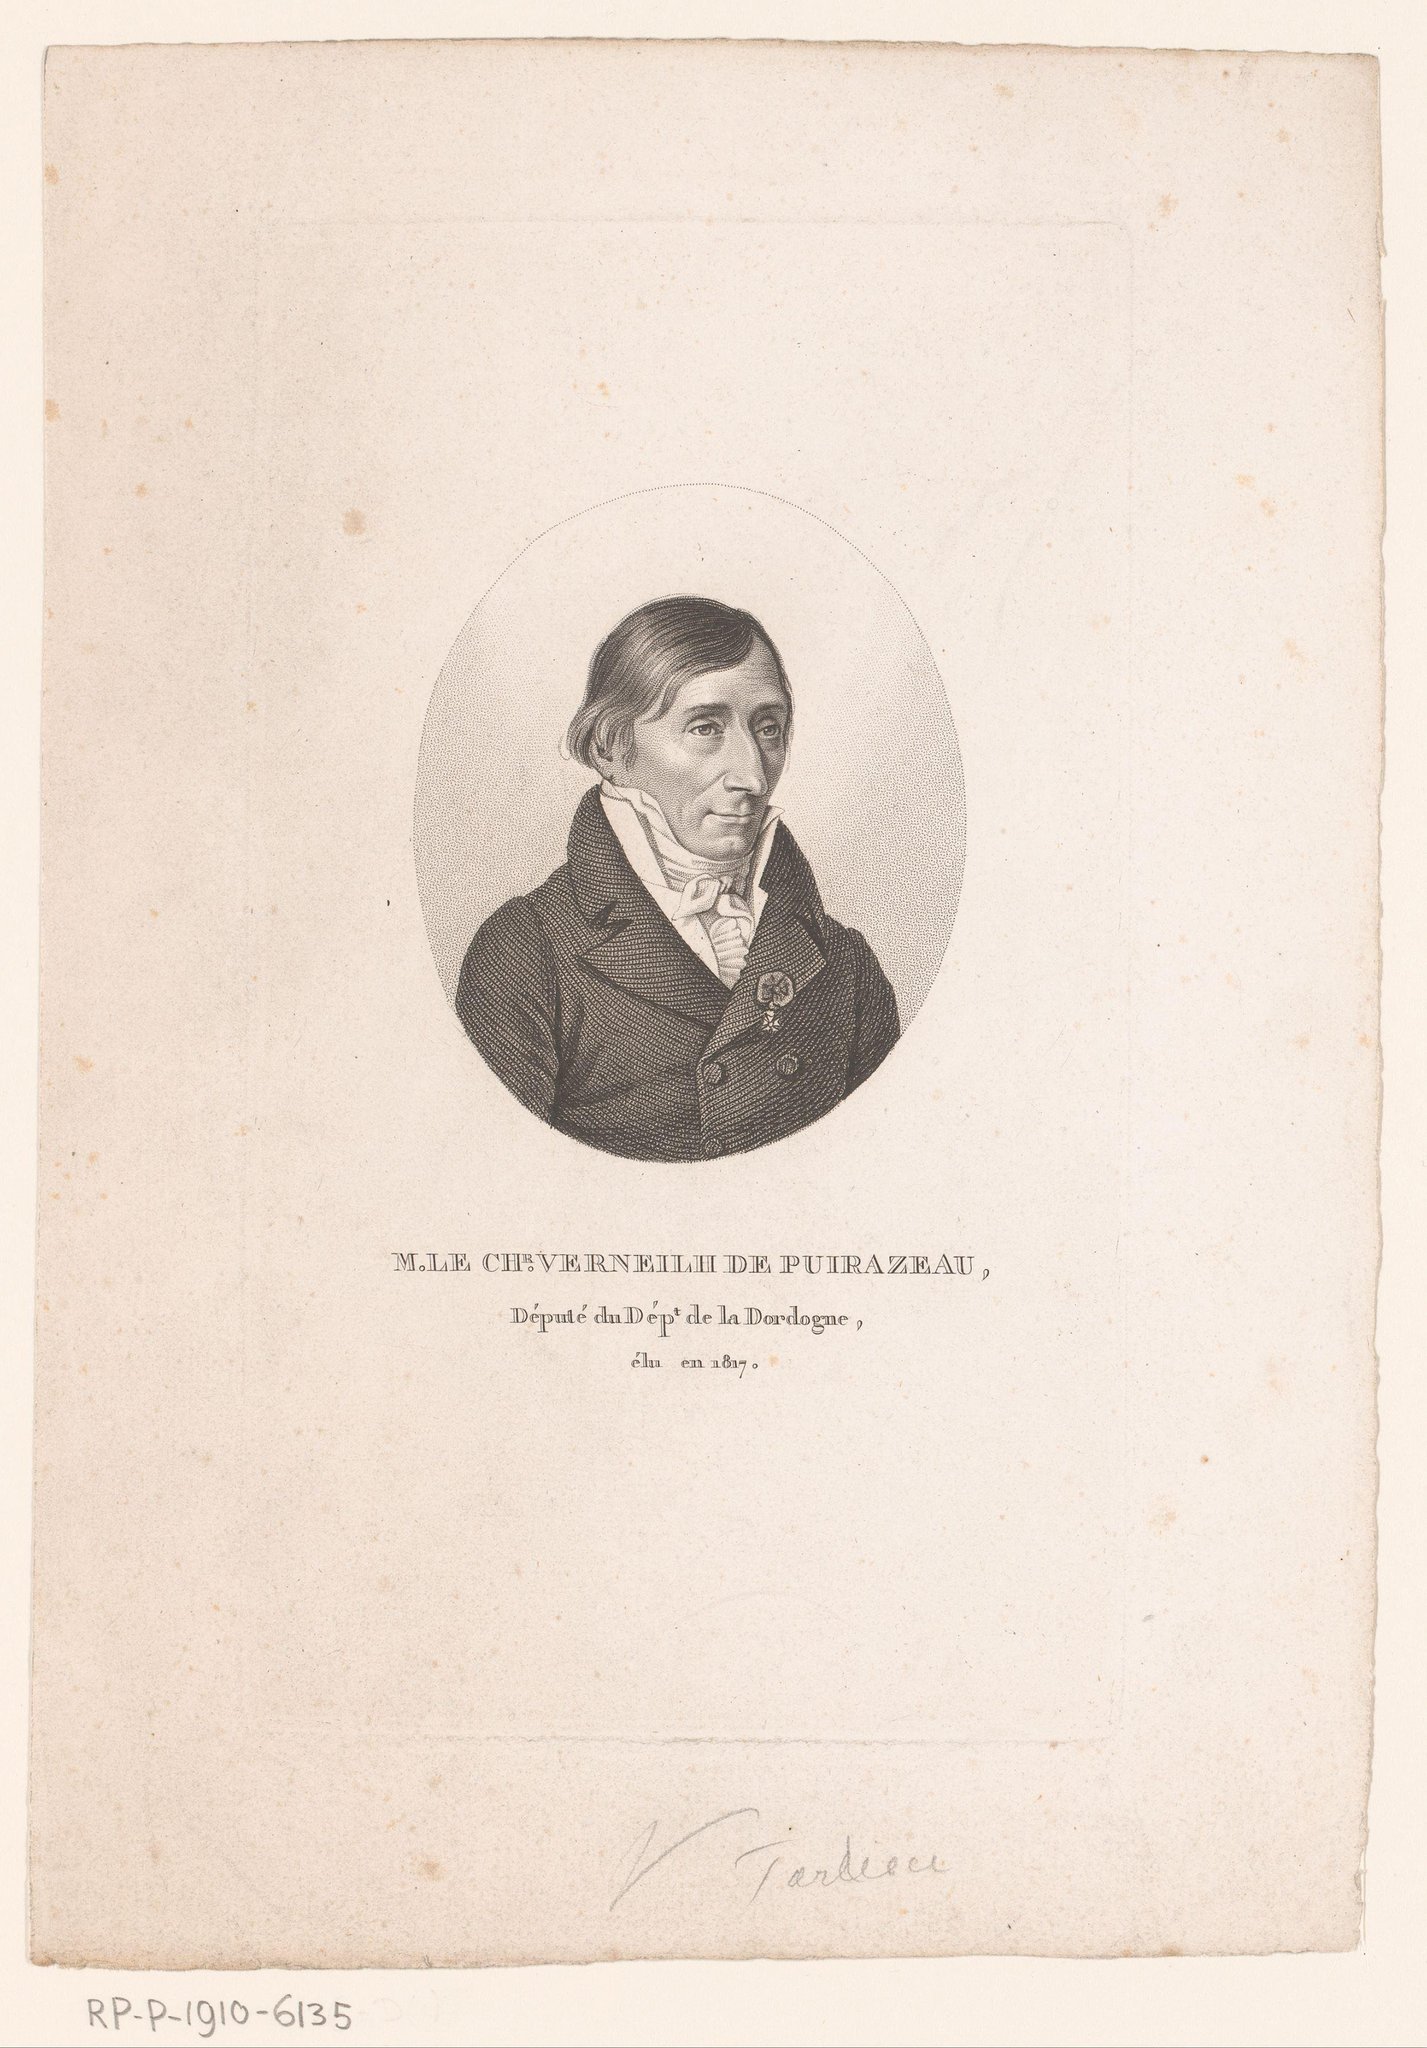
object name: print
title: Portret van Jean-Joseph de Verneilh-Puyraseau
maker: ambroise tardieu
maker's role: print maker, printer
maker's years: 1788-1841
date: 1820-1821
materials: paper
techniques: engraving, roulette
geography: paris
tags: historical persons, politician, e.g. party leader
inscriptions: collector's mark: Lugt 2228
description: Prent uit: Tardieu, Ambroise. Portraits des députés, écrivains et pairs constitutionnels, défenseurs invariables de la charte et de la loi des élections du 5 février 1817. Parijs: Tardieu, Ambroise, 1820-1821.